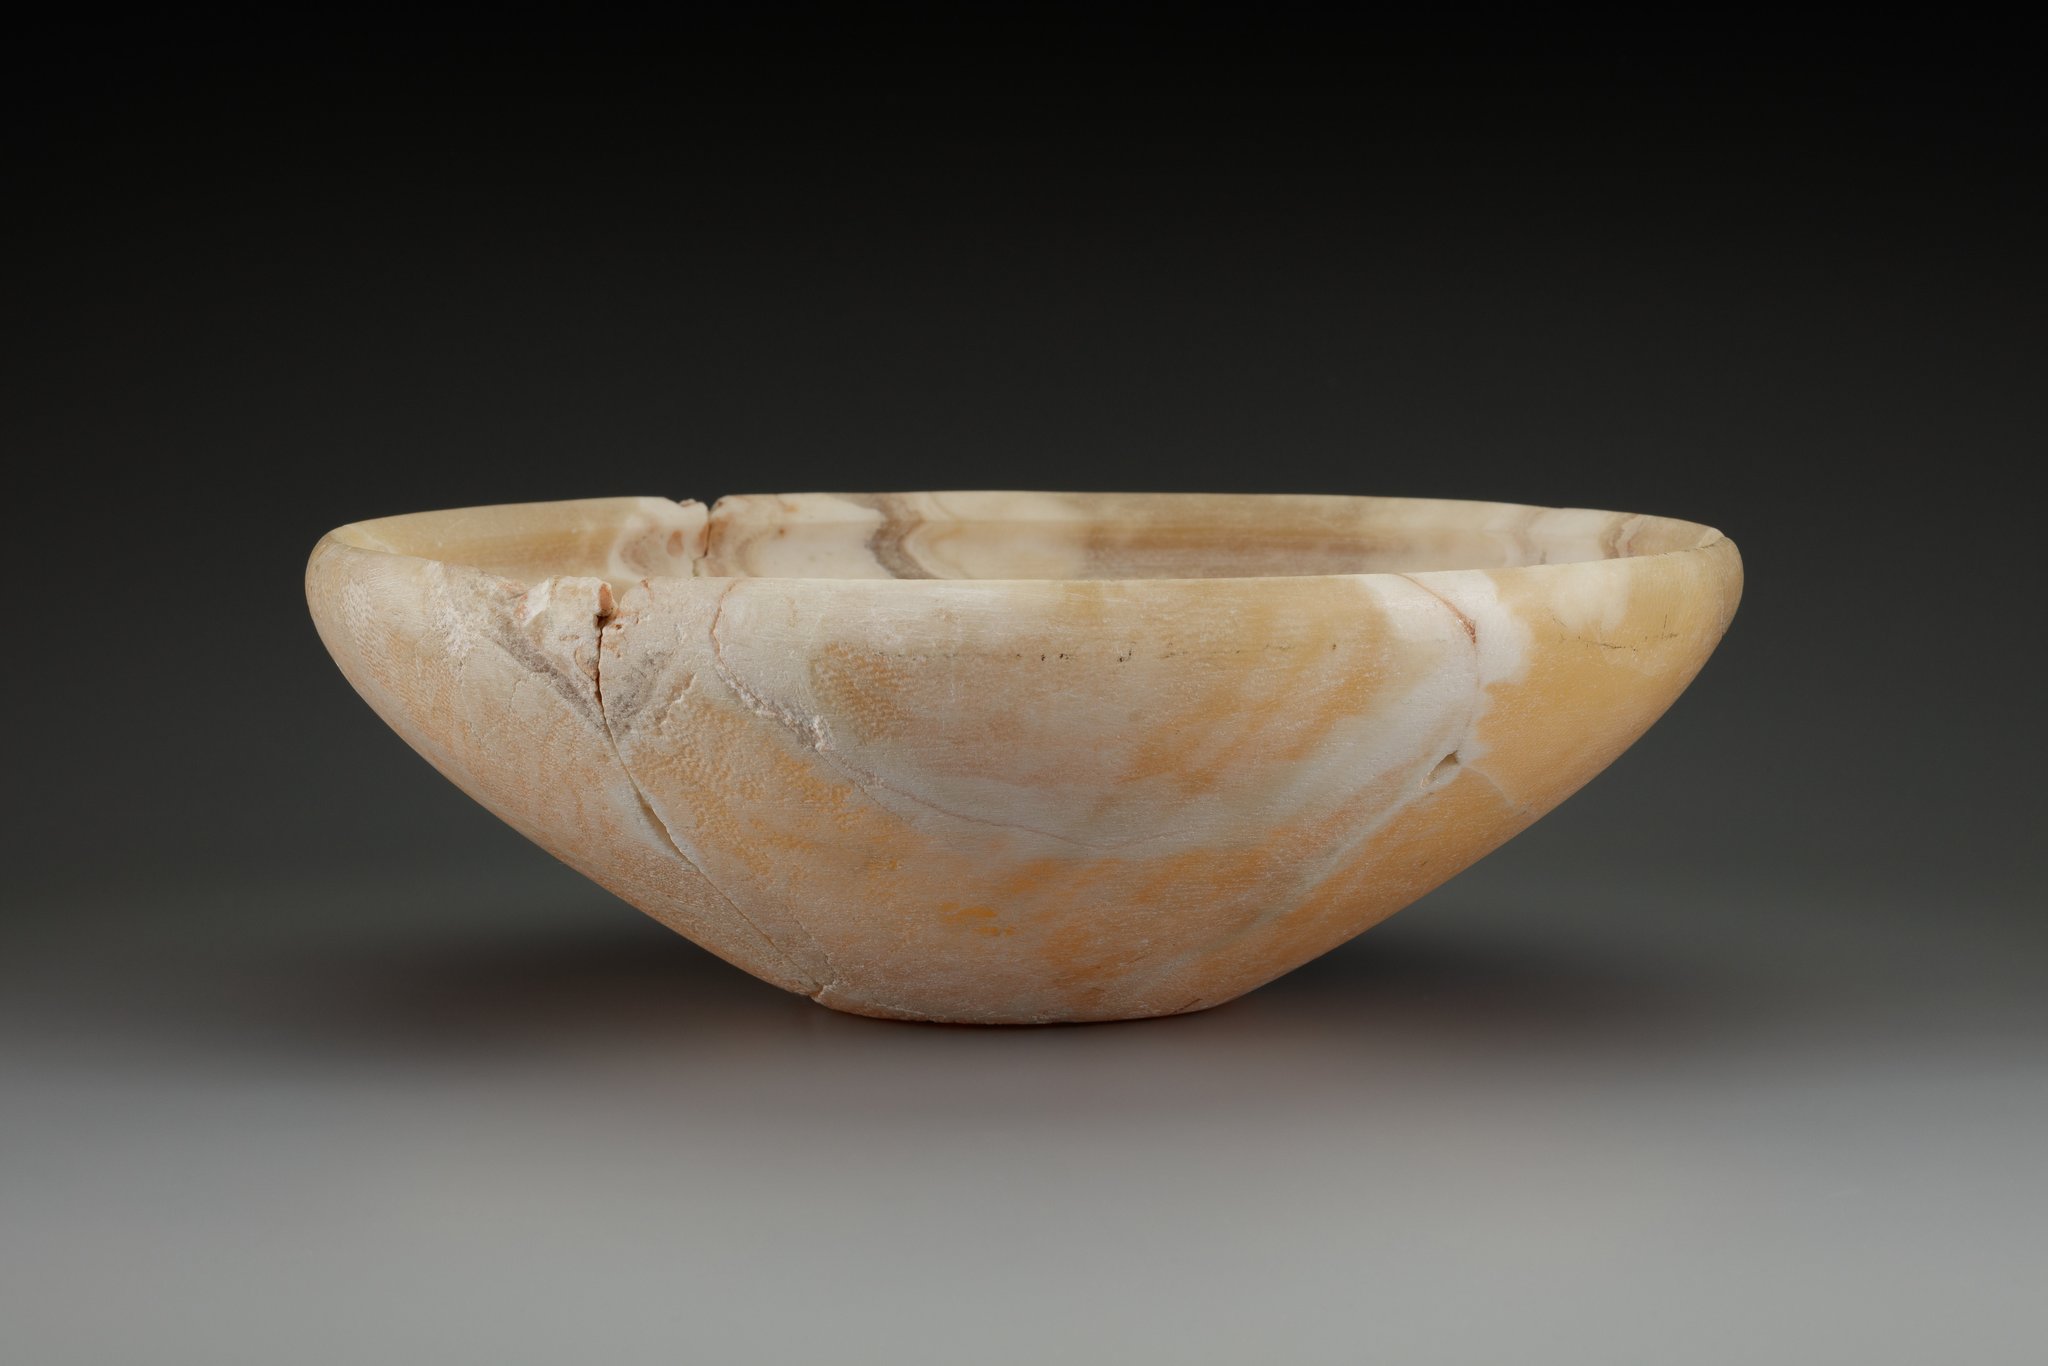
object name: bowl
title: Shallow bowl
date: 3100-2649 BCE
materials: stone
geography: egypt